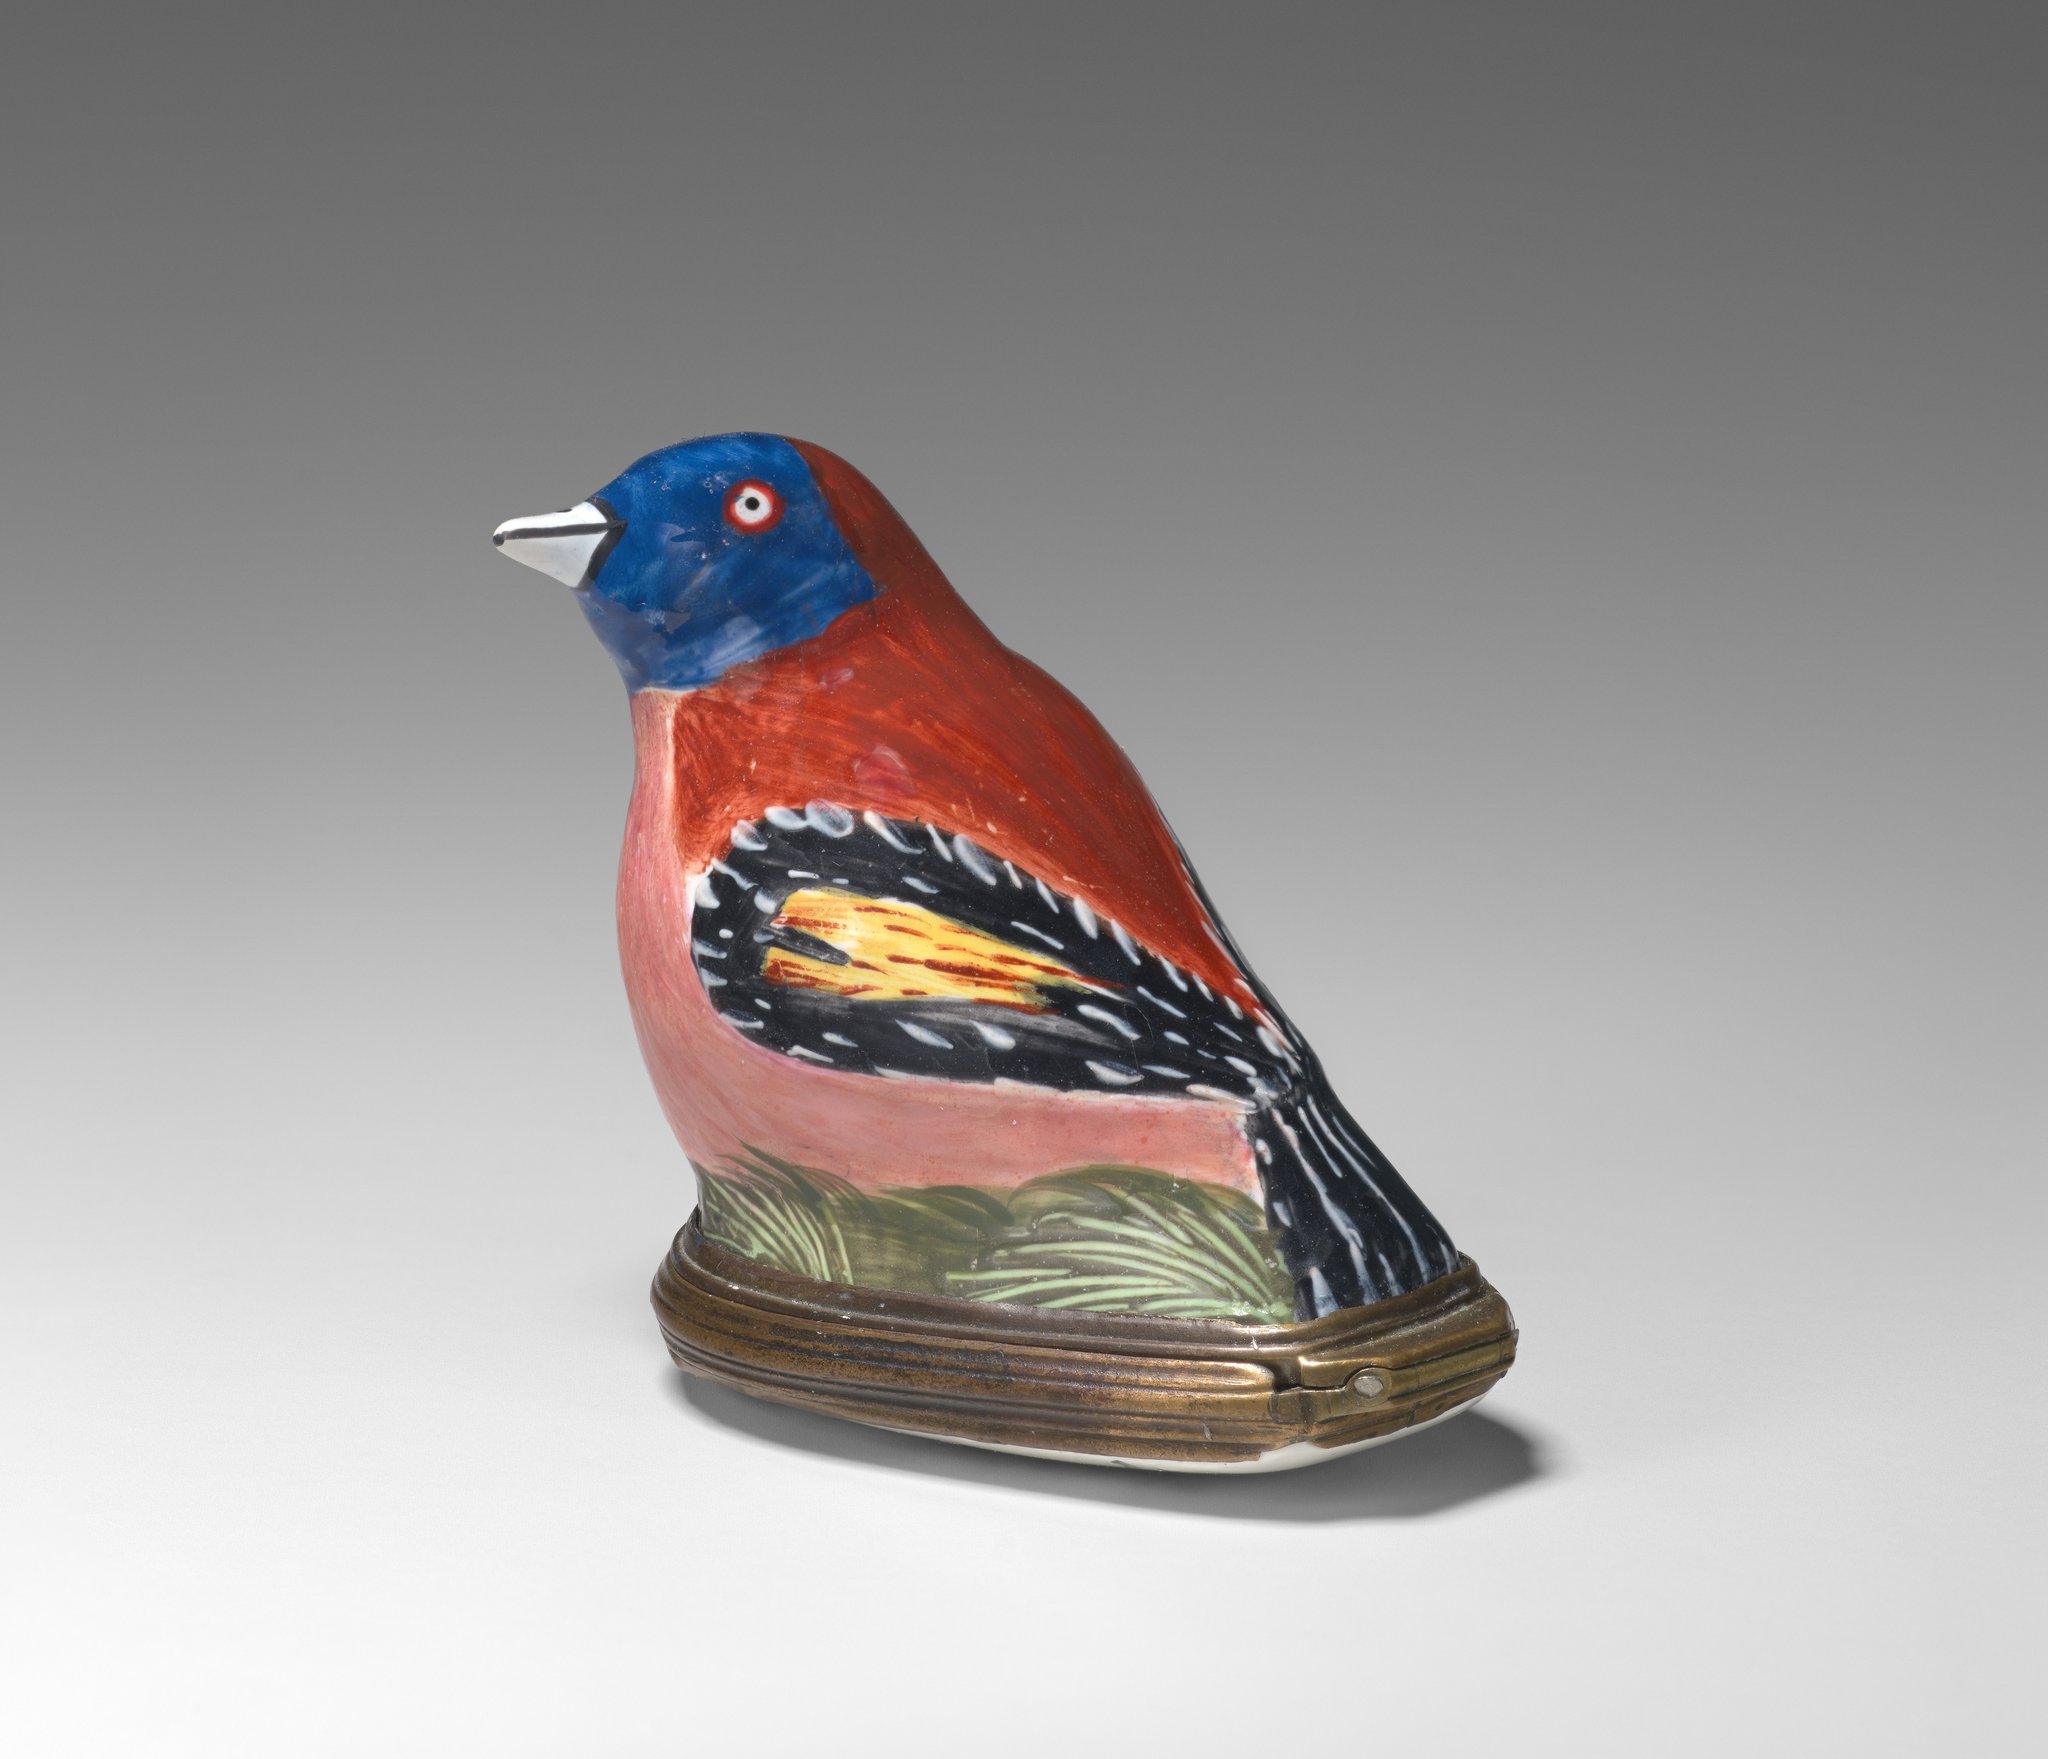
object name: bonbonnière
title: Bonbonnière in the form of a fantastical bird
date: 1770-1780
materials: copper, enamel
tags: birds